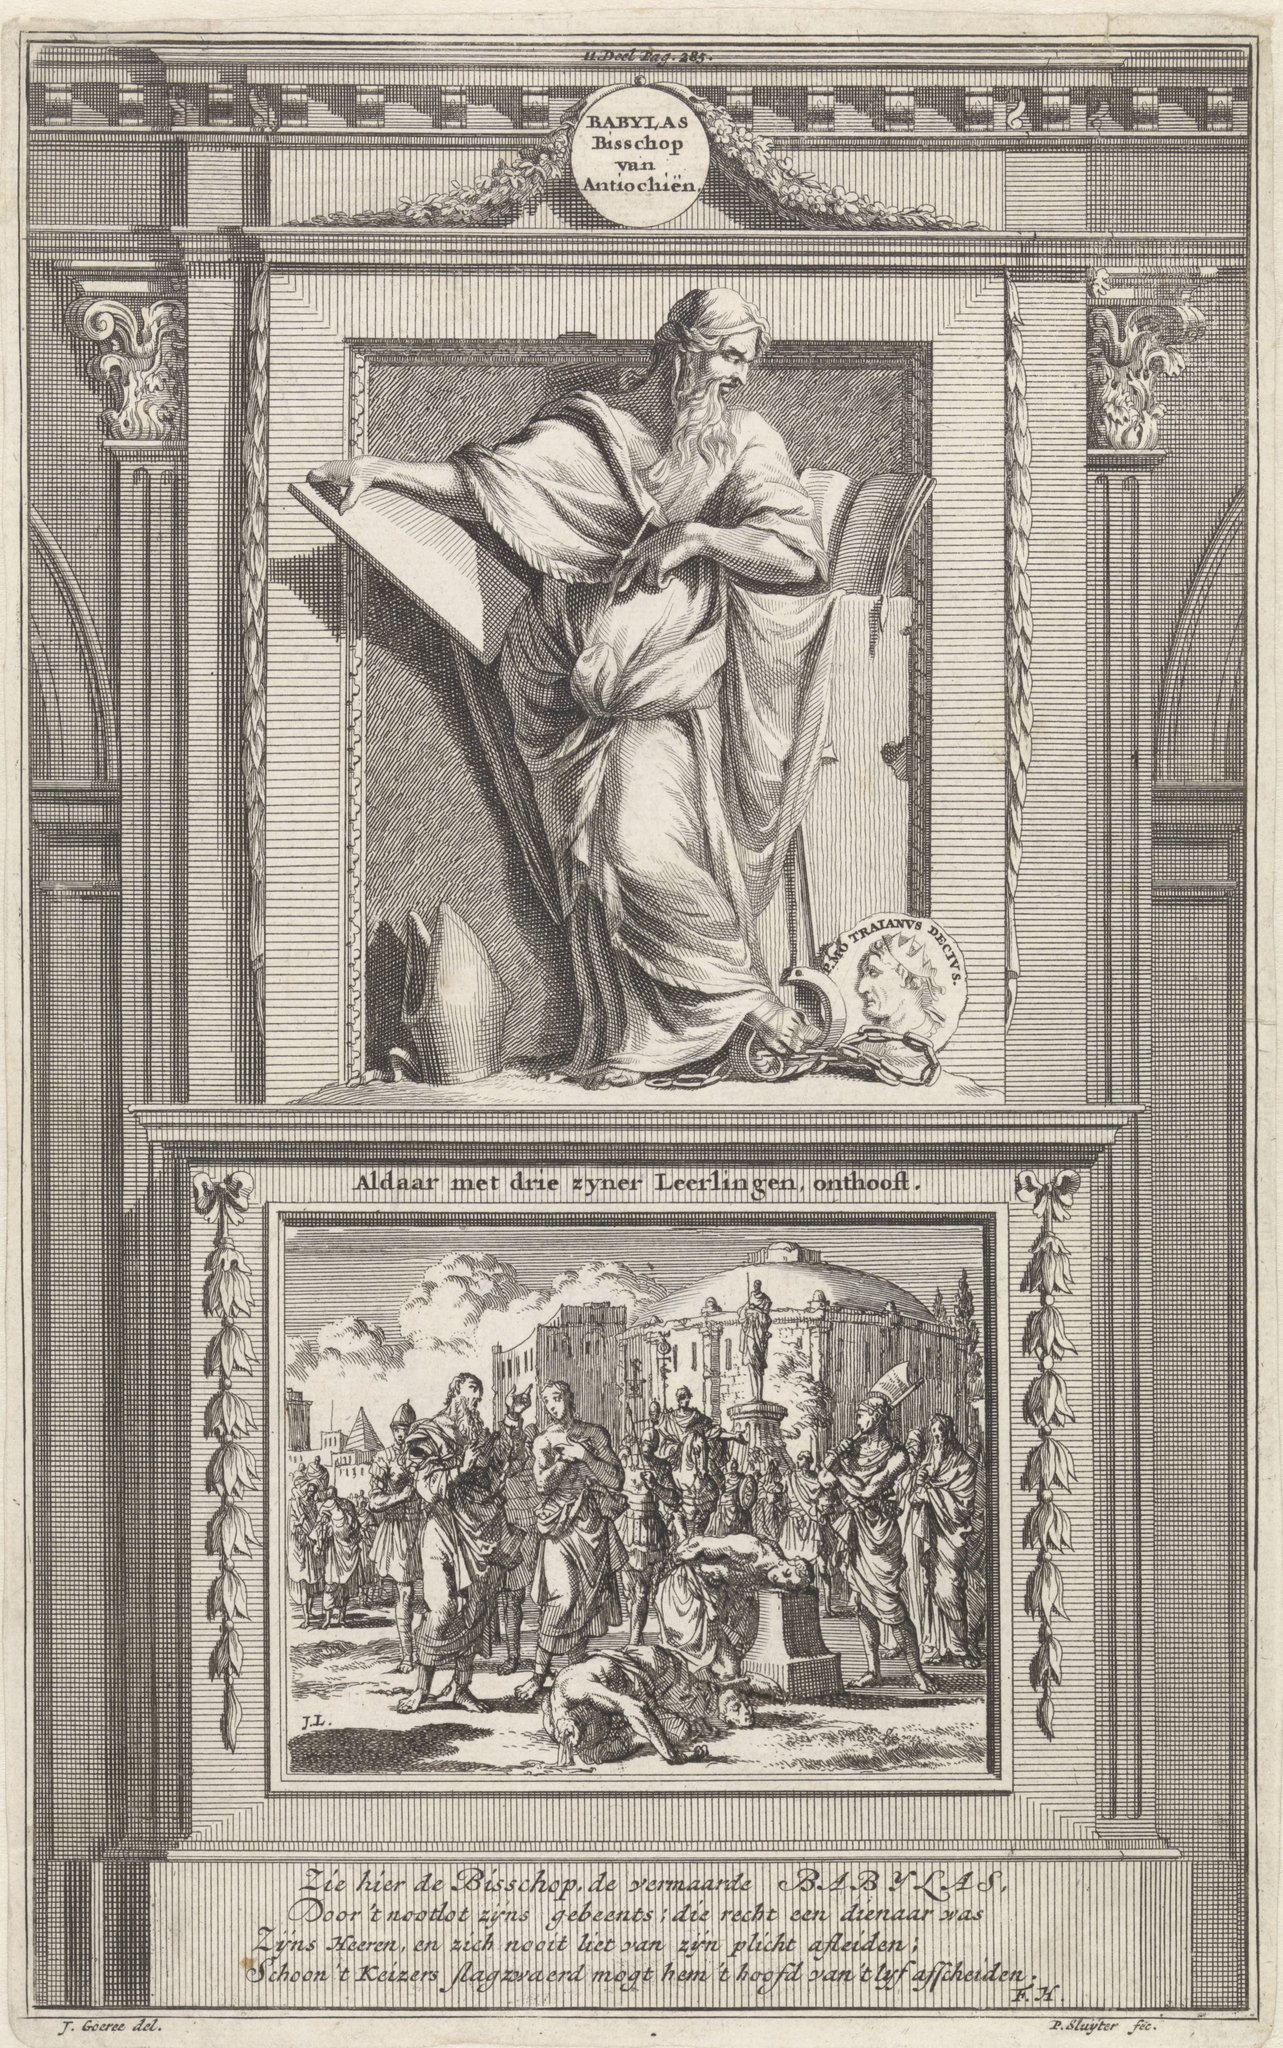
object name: book illustration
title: H. Babylas van Antiochië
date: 1698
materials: paper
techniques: engraving, etching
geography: amsterdam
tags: male saints (babylas) - martyrdom, suffering, misfortune, death of male saint, male saints (with name), violent death by beheading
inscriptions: collector's mark: Lugt 2228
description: De heilige Babylas van Antiochië bestudeert een boek en houdt daarbij een pen en schrijftablet in de aanslag. Babylas staat op een sokkel waar op de voorzijde zijn onthoofding en die van zijn drie leerlingen in beeld is gebracht. Prent middenboven gemerkt: II: Deel Pag. 285.